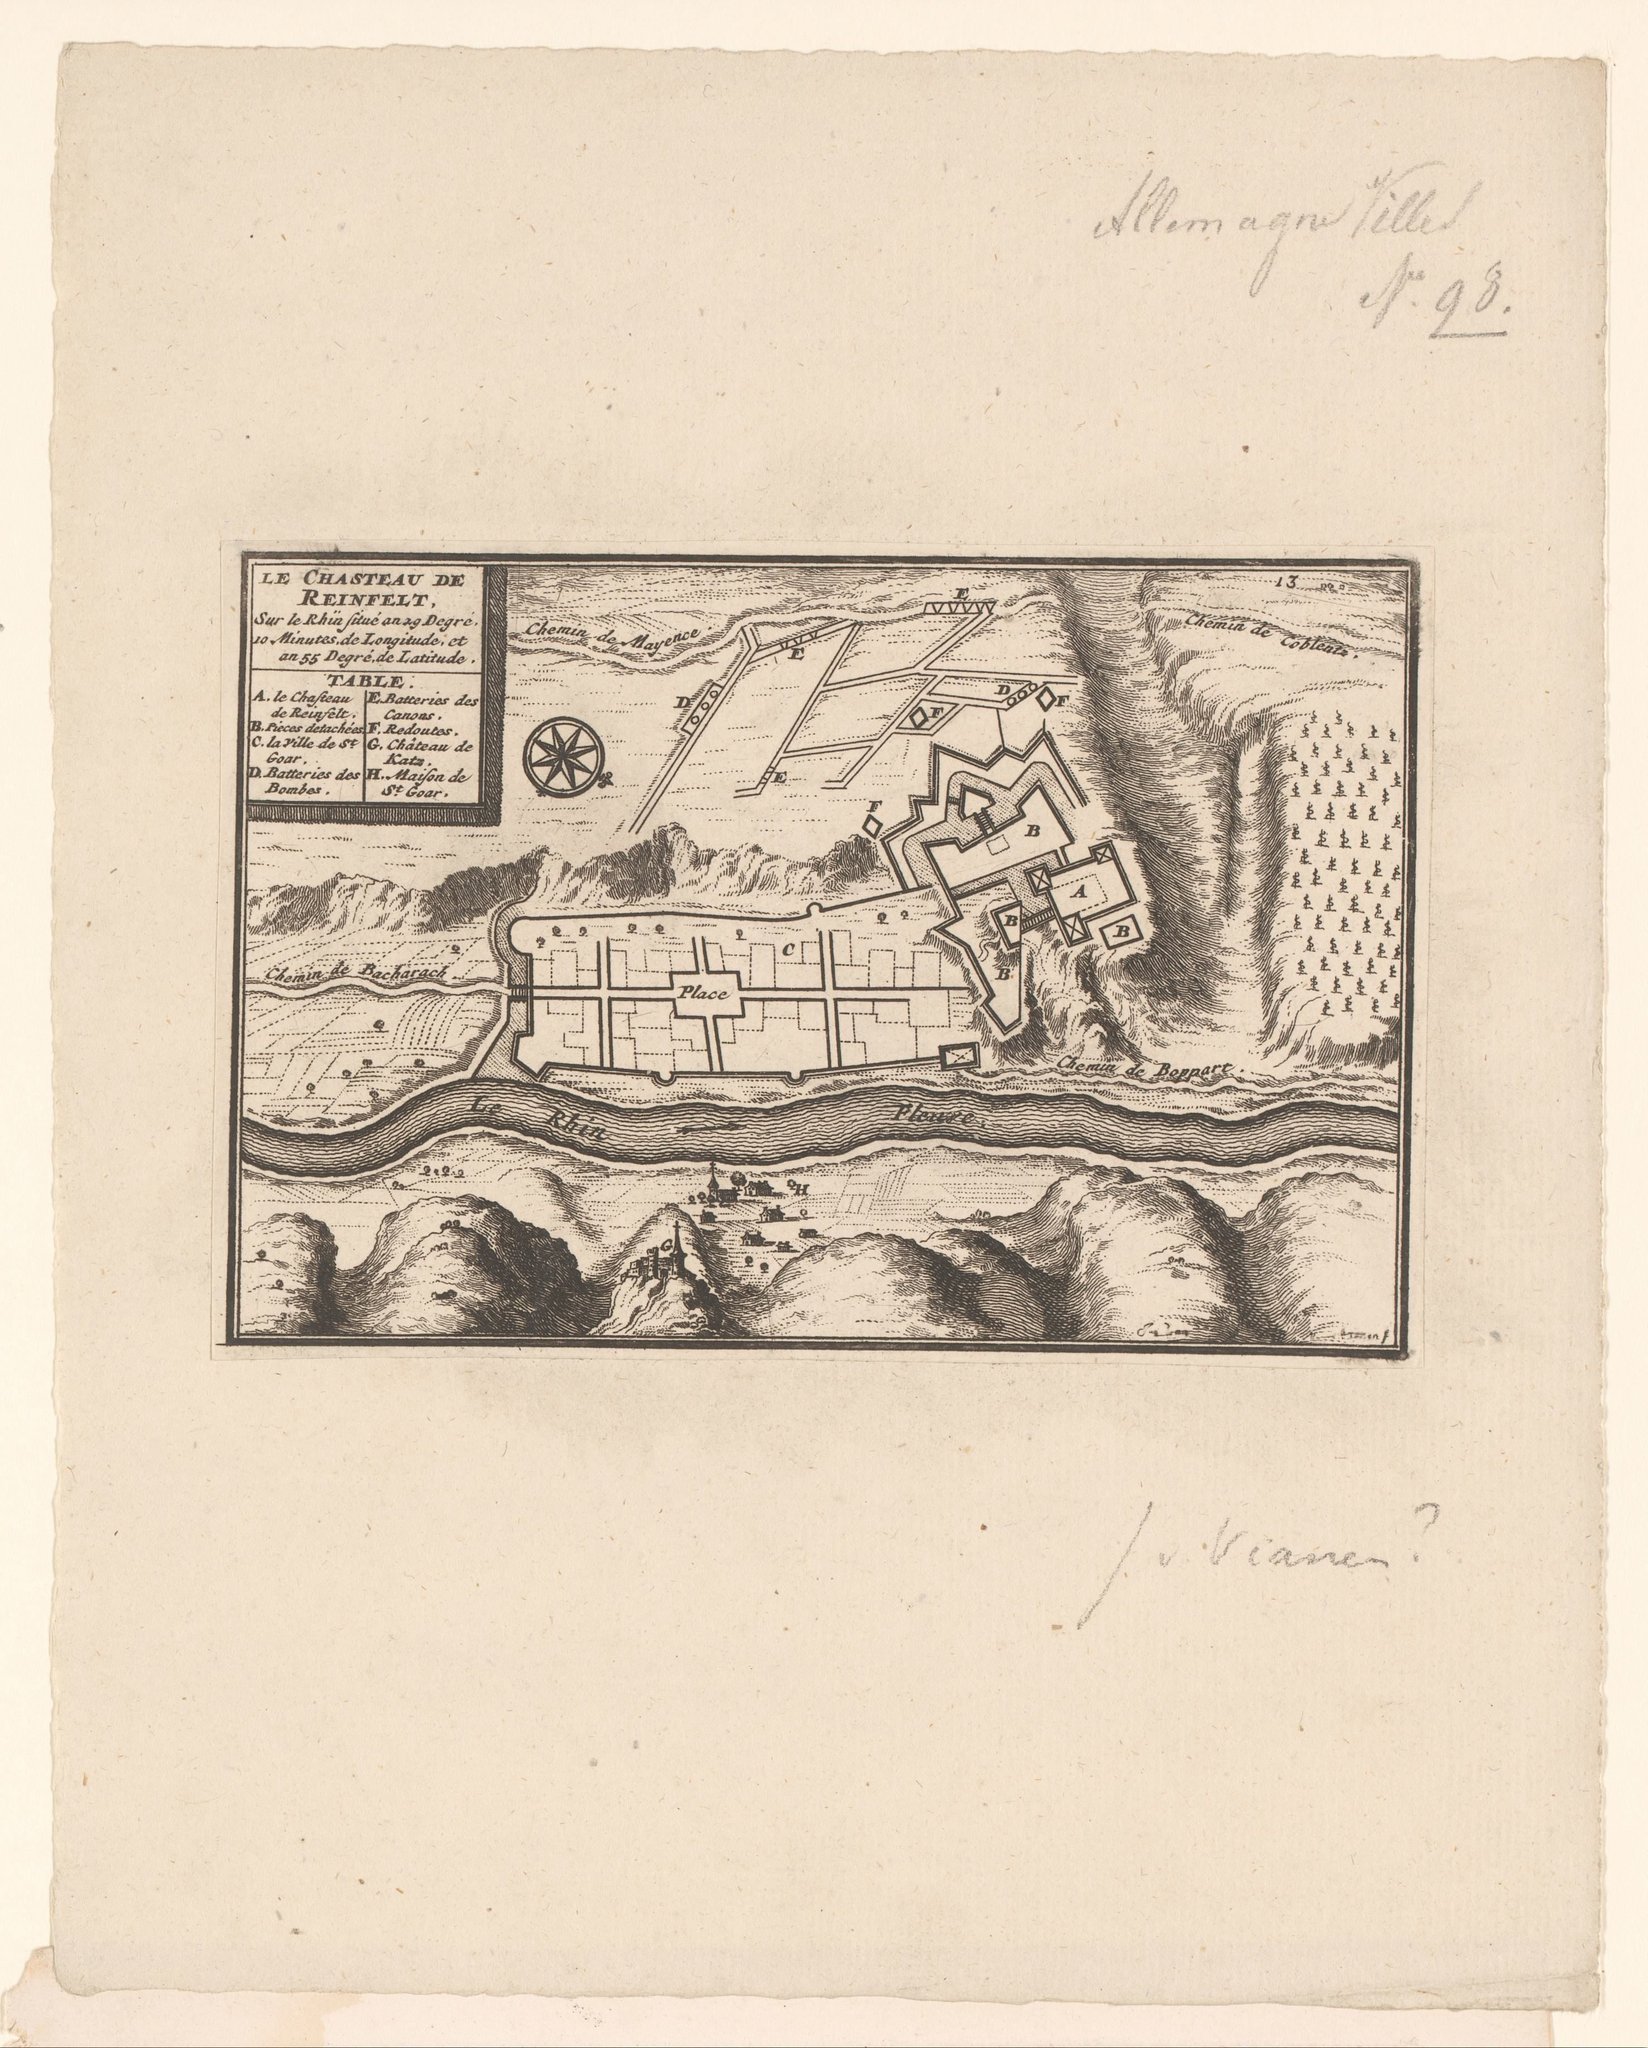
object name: area plan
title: Plattegrond van Burcht Rheinfels, bij Sankt Goar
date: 1702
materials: paper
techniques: engraving, etching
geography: amsterdam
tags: castle, maps of cities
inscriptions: collector's mark: Lugt 2228